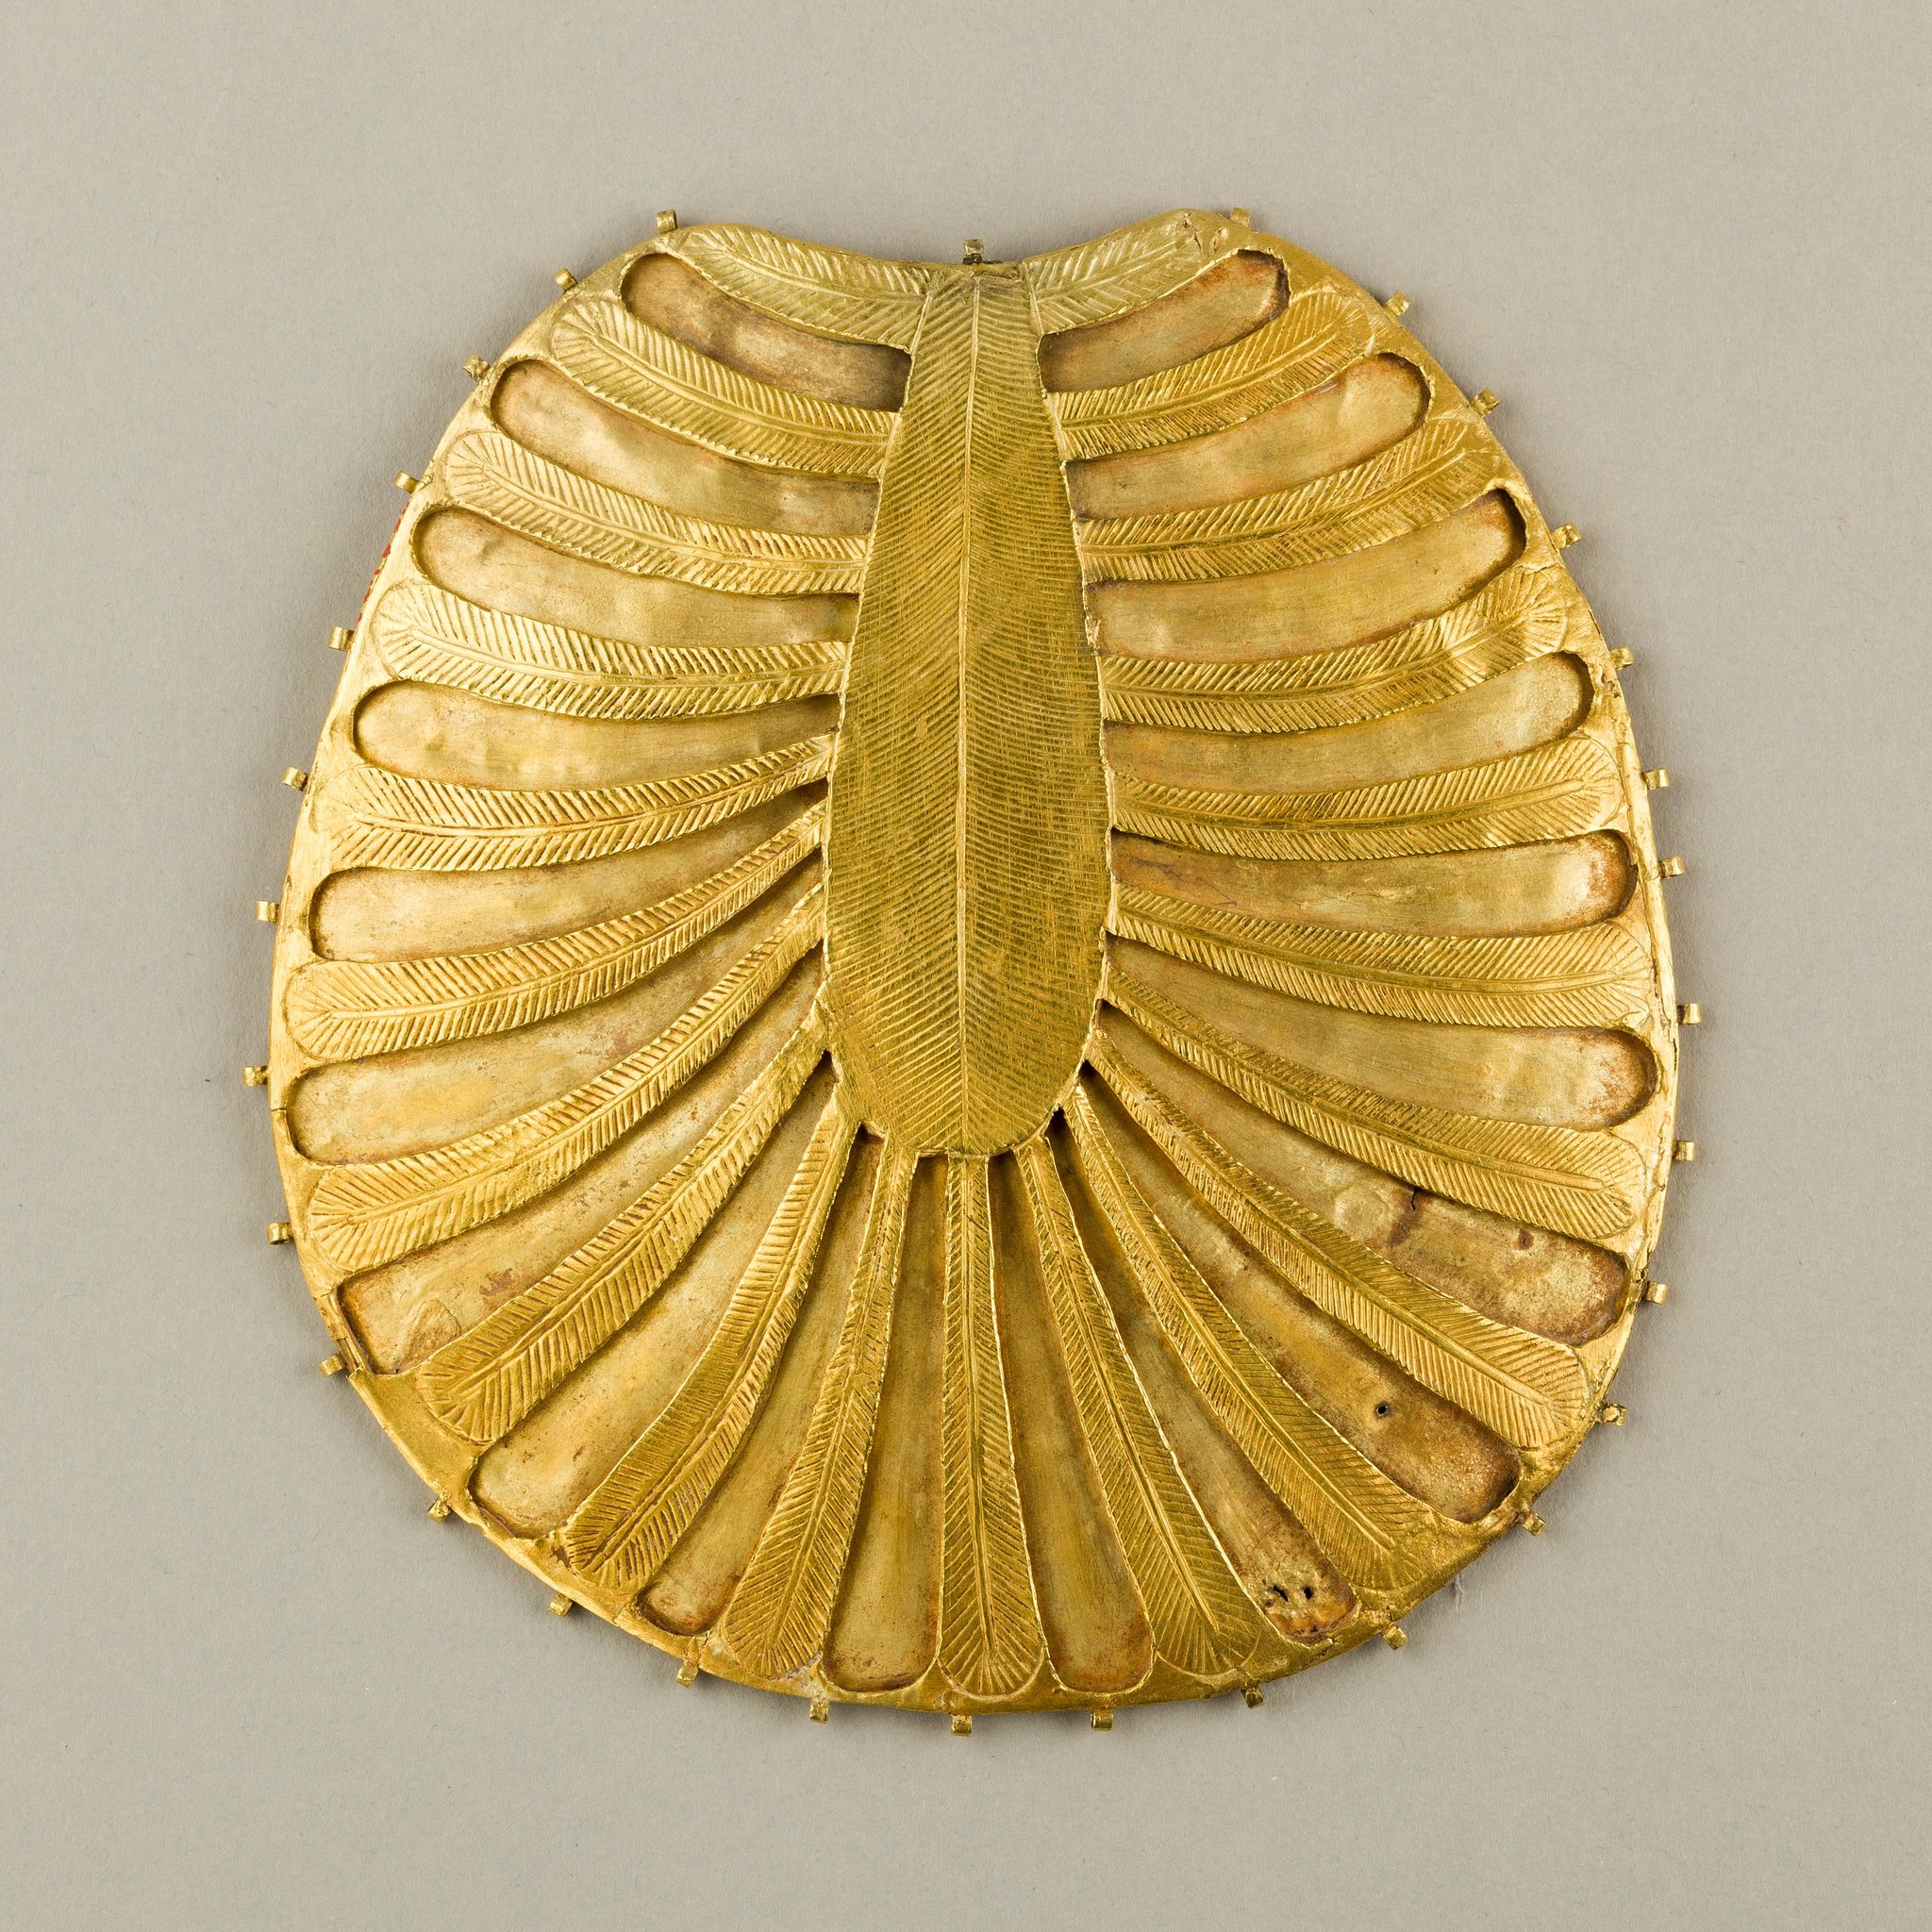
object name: disk, formerly reconstructed a headpiece of a wig cover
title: Disk Made of Two Sheets of Gold, One Concave the Other Decorated with Feathers or Palm Fronds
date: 1479-1425 BCE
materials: gold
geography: egypt